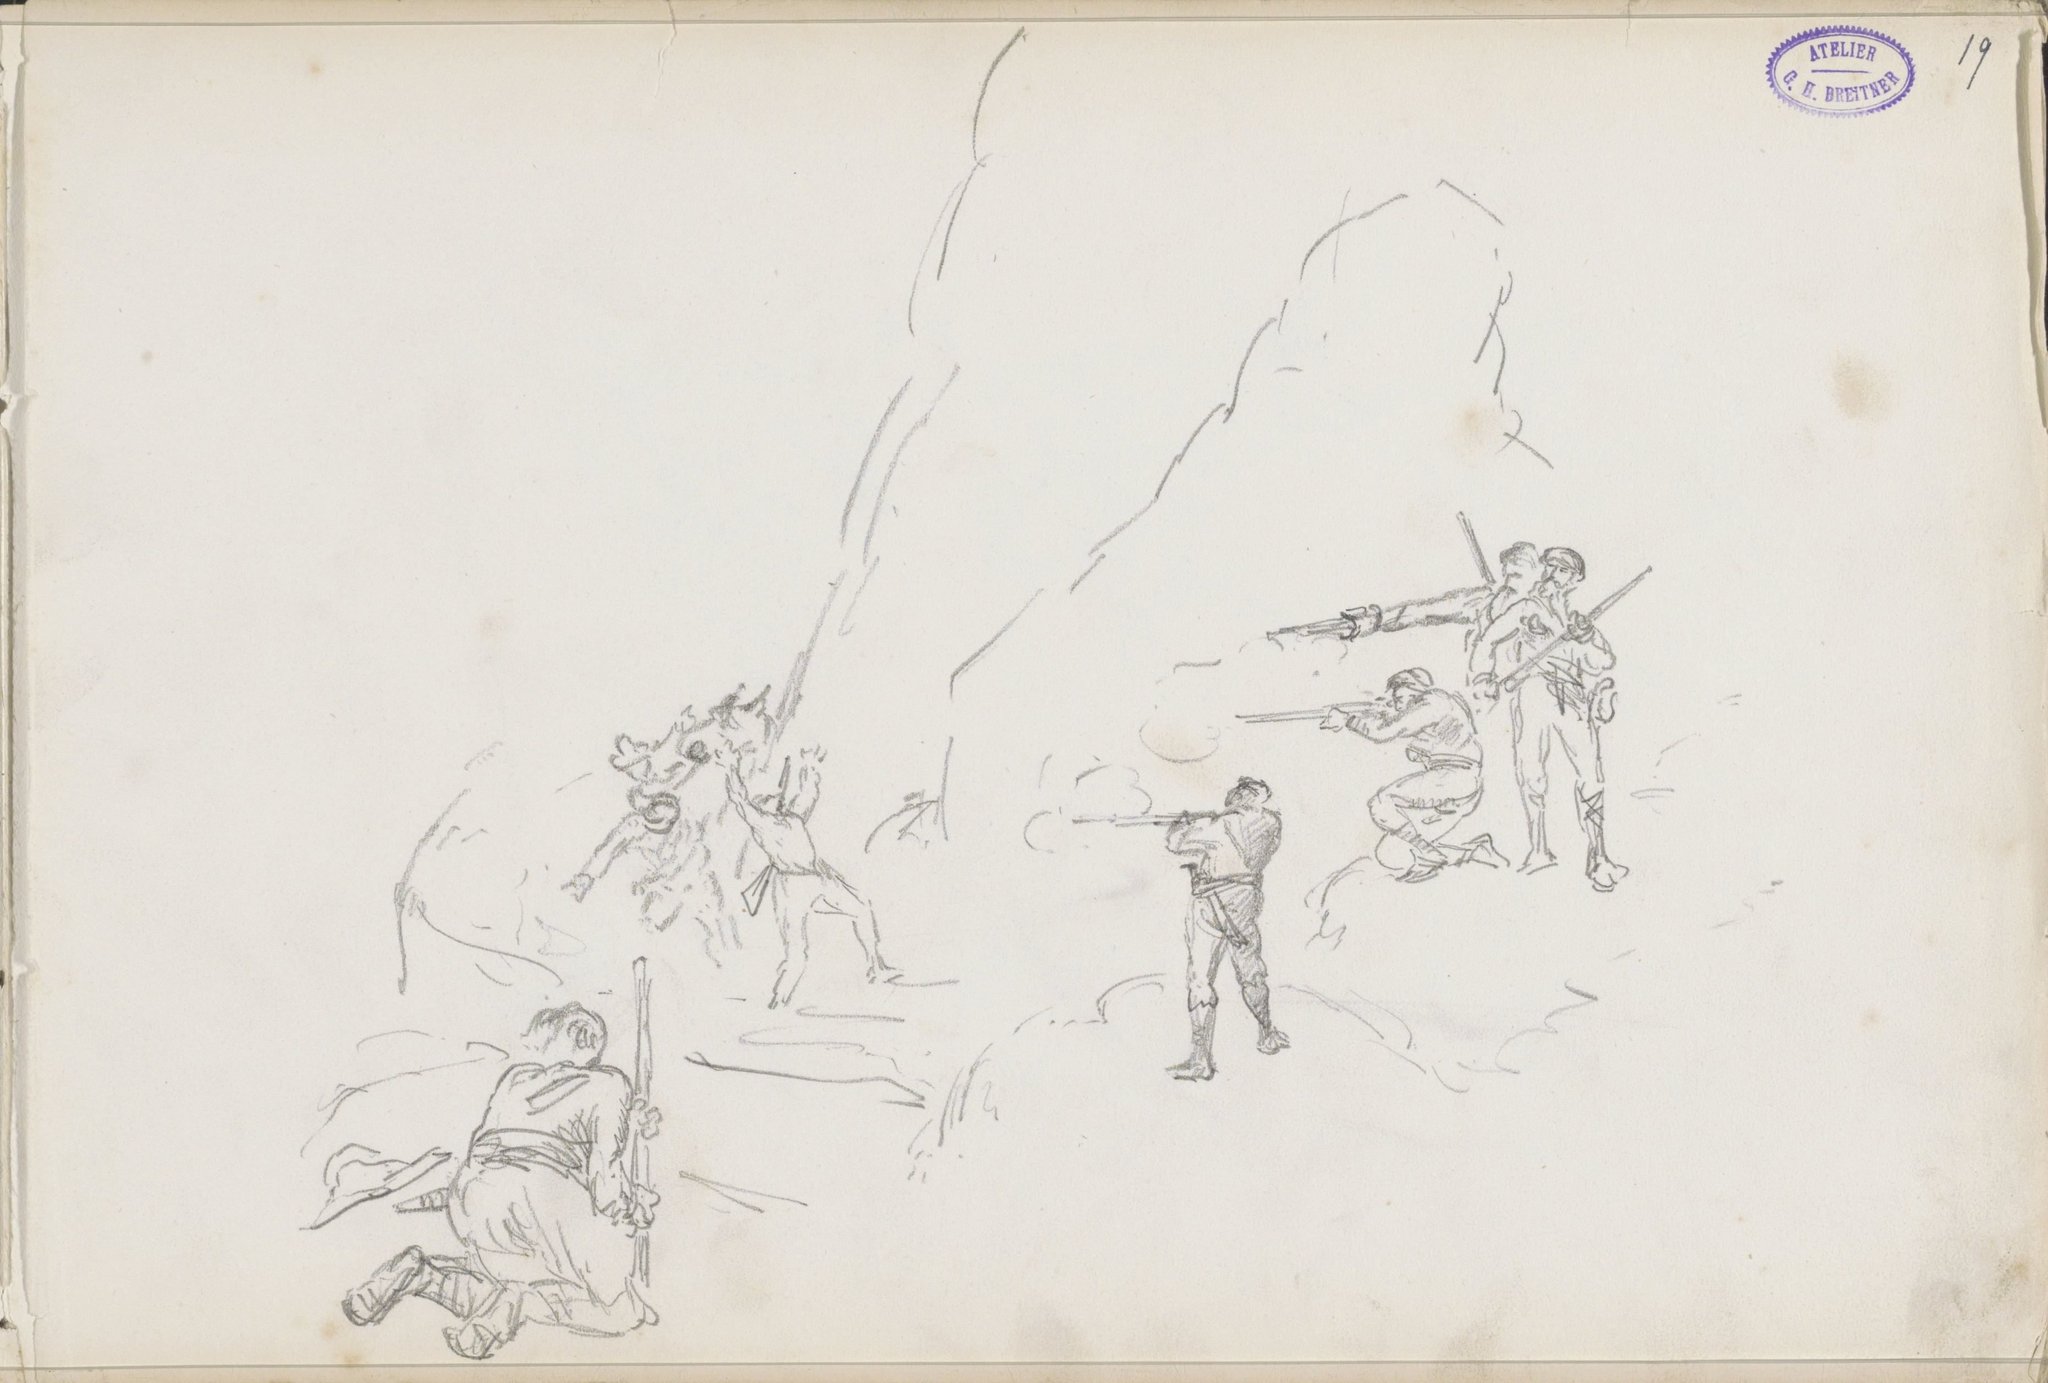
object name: sketchbook leaf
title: Strijdende soldaten in een rotsachtig landschap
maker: george hendrik breitner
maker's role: draughtsman, painter, print maker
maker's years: 1857-1923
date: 1809-1872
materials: paper, pencil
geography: rotterdam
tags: division of armed forces (+ during the battle), division of armed forces (+ land forces), firearms: rifle, rocks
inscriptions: workshop stamp: Lugt 291d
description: Blad 19 recto uit een schetsboek met 32 bladen.